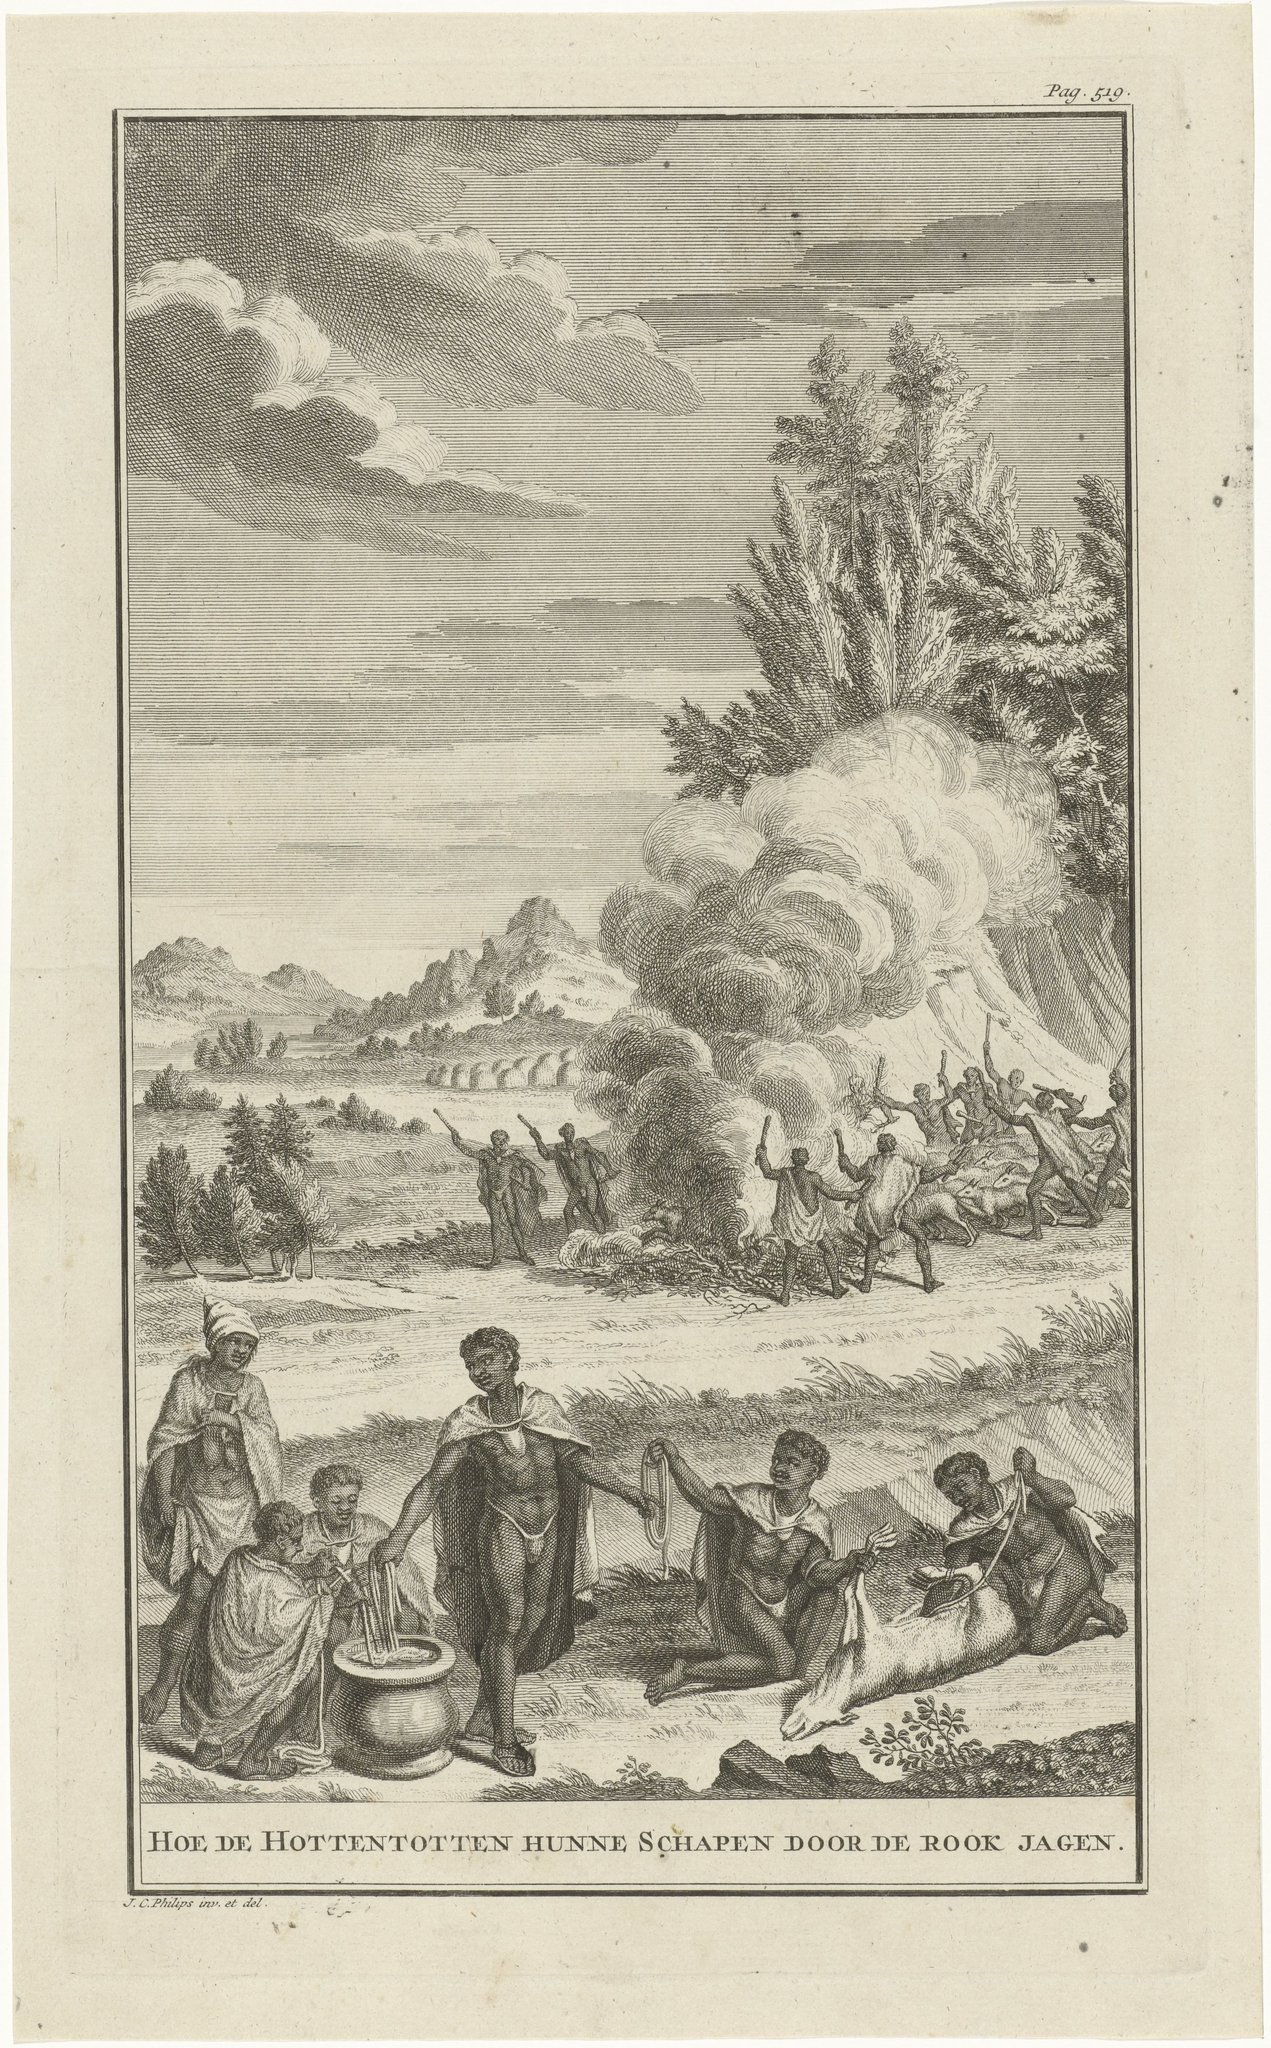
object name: print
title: Khoikhoi slachten hun schapen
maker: jan caspar philips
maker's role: draughtsman, print maker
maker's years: 1700-1775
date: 1727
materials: paper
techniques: engraving, etching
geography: amsterdam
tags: sheep (+ animal killed by man), khoikhoi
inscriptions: collector's mark: Lugt 2228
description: Prent als illustratie gebruikt in: Kolbe, Peter. Naaukeurige en uitvoerige beschryving van de kaap de Goede Hoop; behelzende een zeer omstandig verhaal van den tegenwoordigen toestant van dat vermaarde gewest ... beschryving van de oorsprong der Hottentotten, deel I, p. 519. Amsterdam: Balthazar Lakeman, 1727.